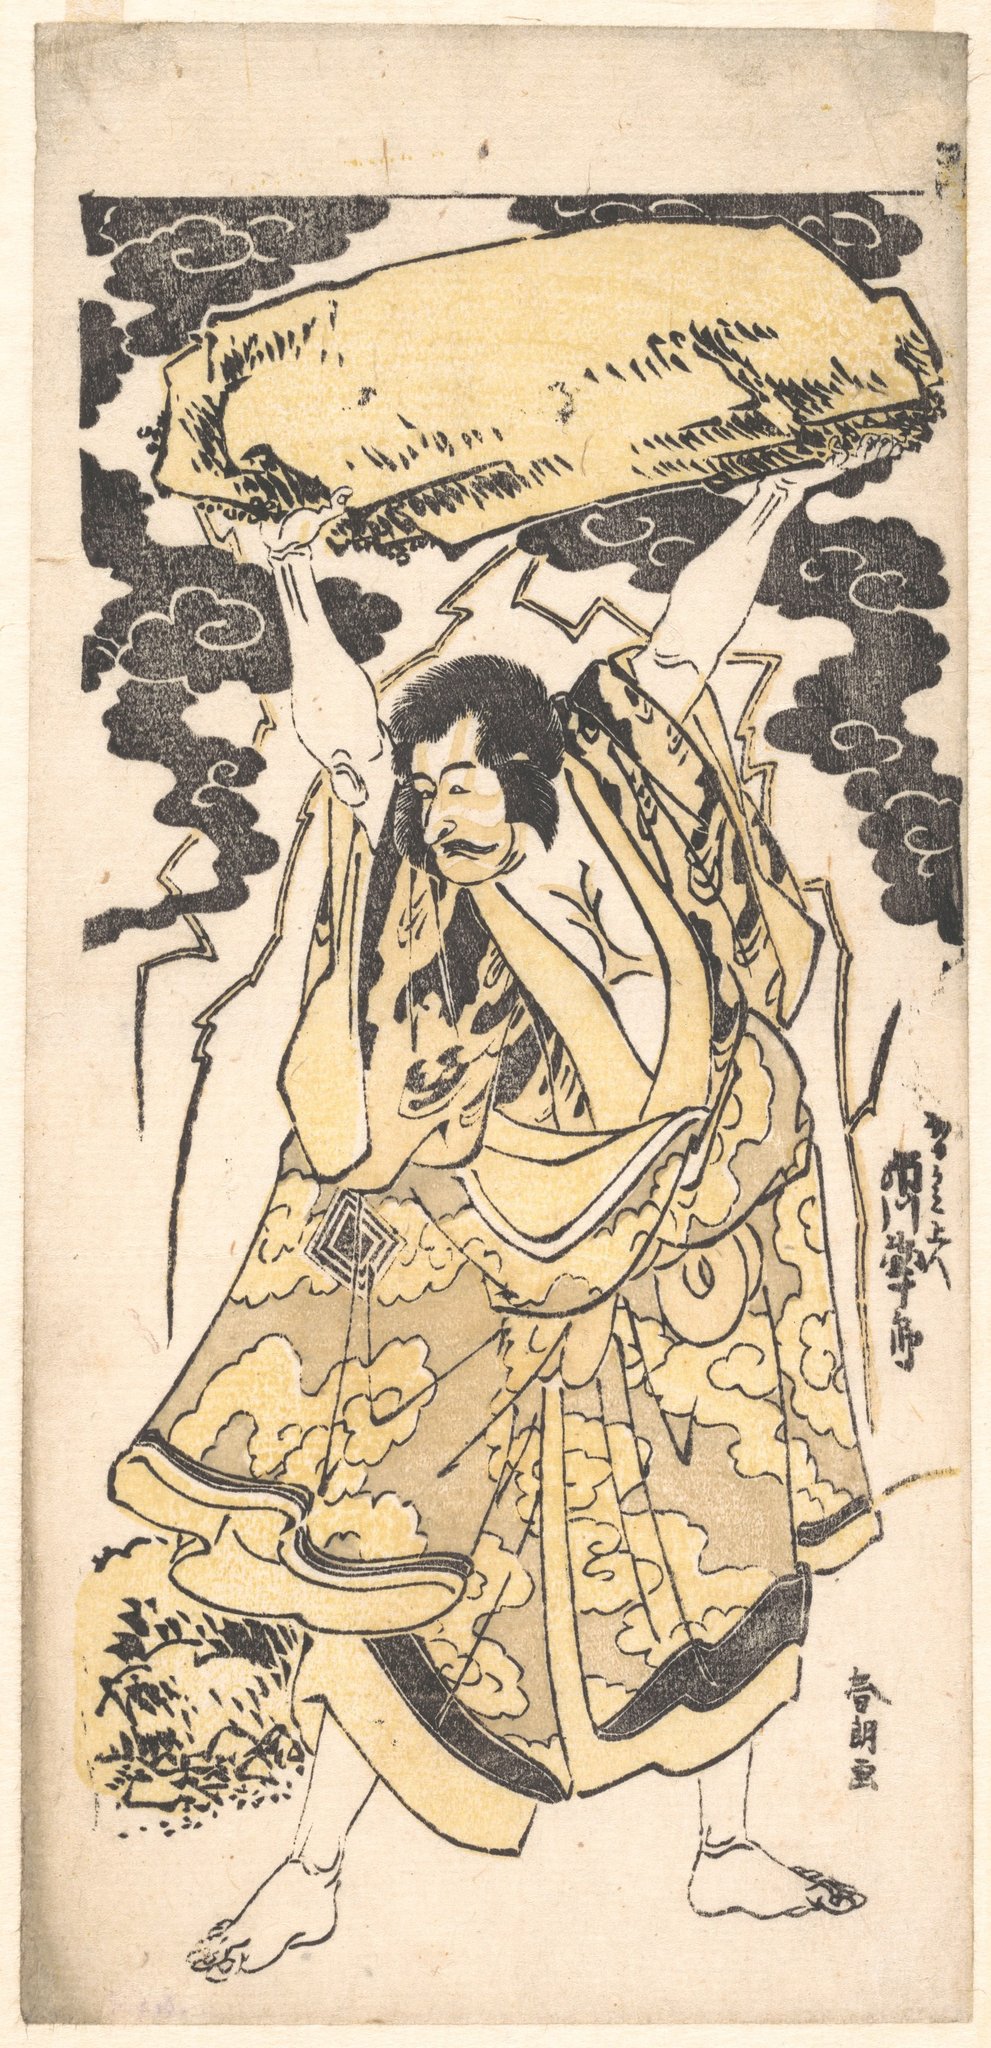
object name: print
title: The Actor Ichikawa Danjuro I 1660–1704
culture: japanese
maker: katsushika hokusai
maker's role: artist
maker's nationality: japanese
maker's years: 1760-1849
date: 1760-1849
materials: ink, paper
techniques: woodblock print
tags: men,actors